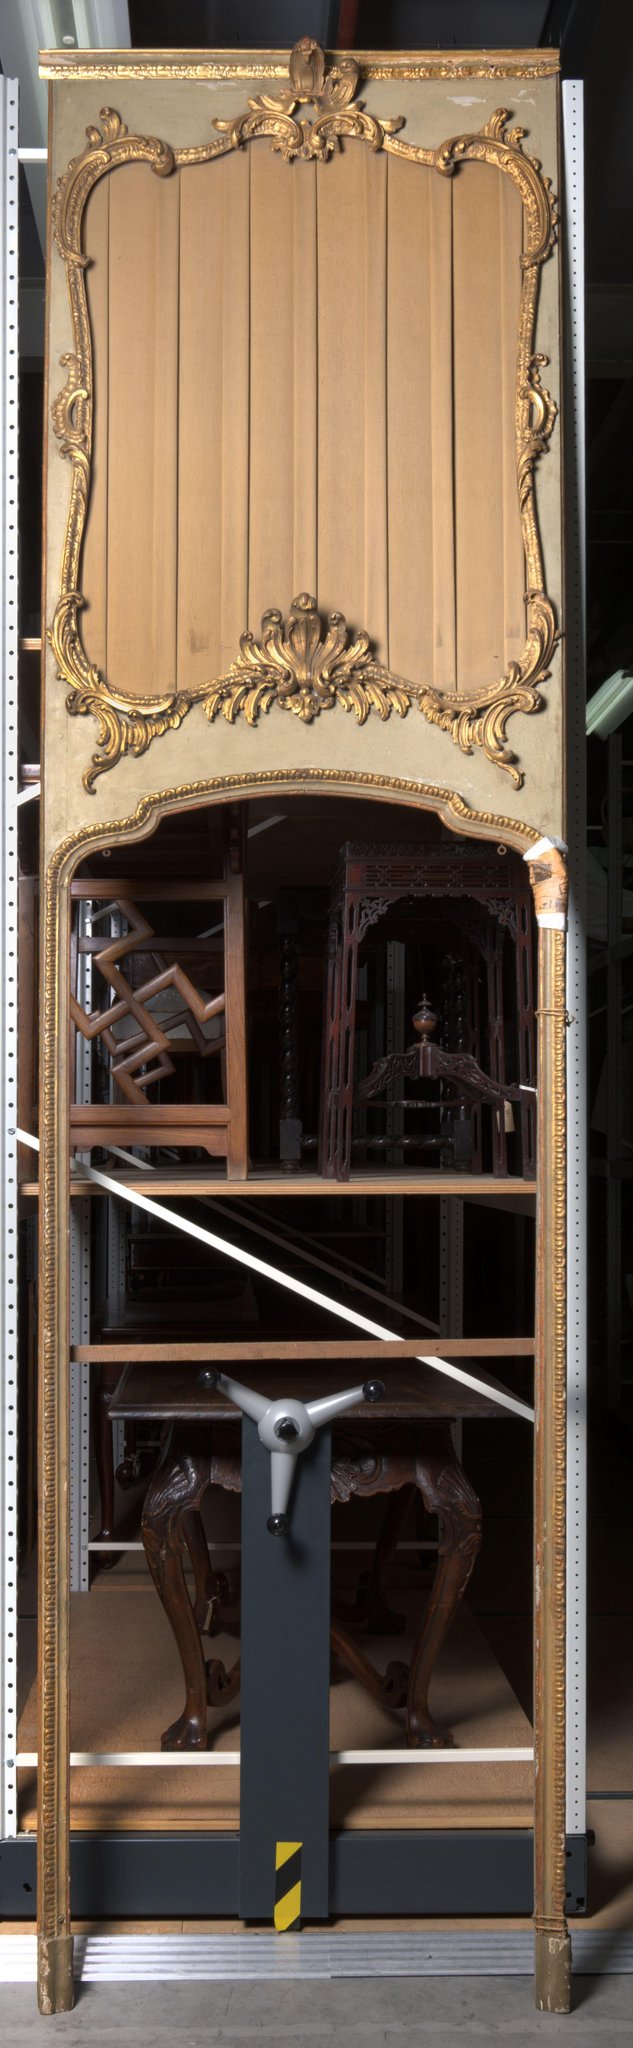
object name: betimmering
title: Bouwfragment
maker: Anonymous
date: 1740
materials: wood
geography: france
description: Delen van een betimmering van grijs met goud geschilderd beukenhout, bestaande uit een kozijn met dessus-de-porte. De dessus-de-porte met gestoken lijsten heeft een geschulpte dorpel en gestrekt S-vormige stijlen. De lijst is versierd met grote C-voluten, rocaillemotieven en in het midden van de onder- en bovendorpel met gestileerde palmetten. Zie voor de bijbehorende deuren: BK-NM-13223-a/b en voor het tweede kozijn: BK-NM-13223-d. De kozijnen fungeerden waarschijnlijk als raamkozijnen.